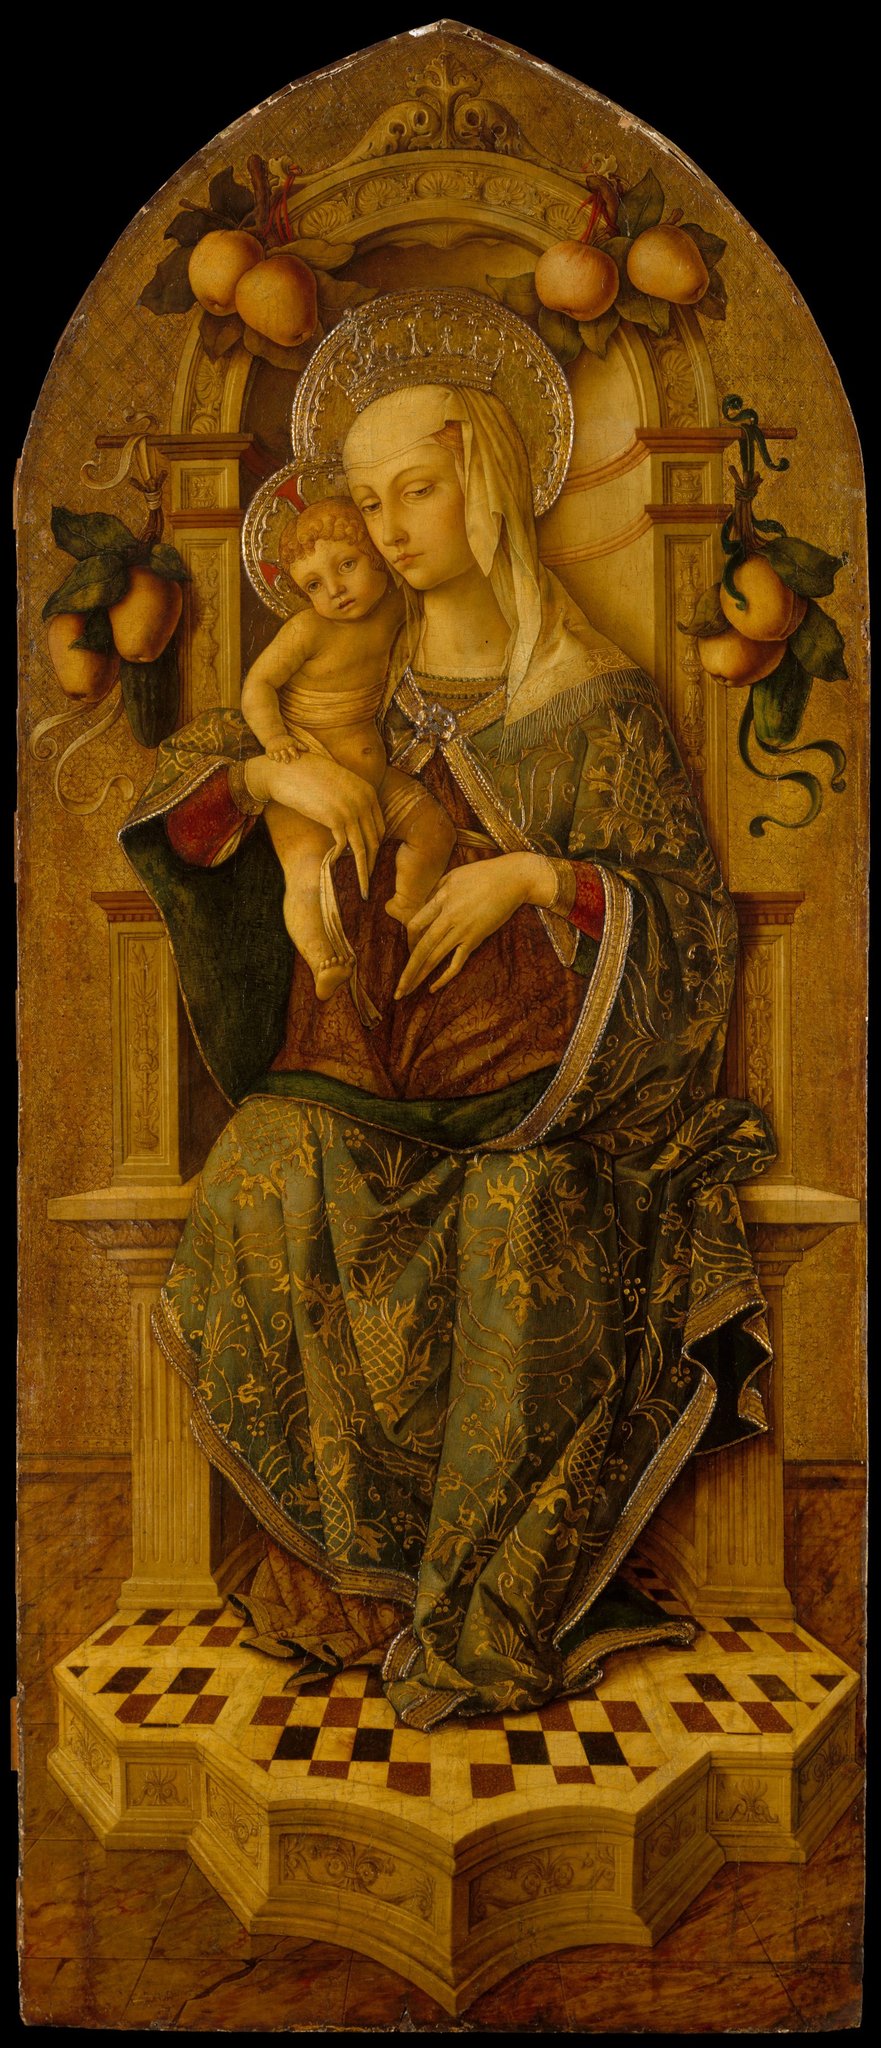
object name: painting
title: Madonna and Child Enthroned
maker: nicola di maestro antonio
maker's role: artist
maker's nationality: italian, active ancona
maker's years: 1472-1510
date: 1475-1490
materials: gold leaf, paint, wood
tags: madonna and child